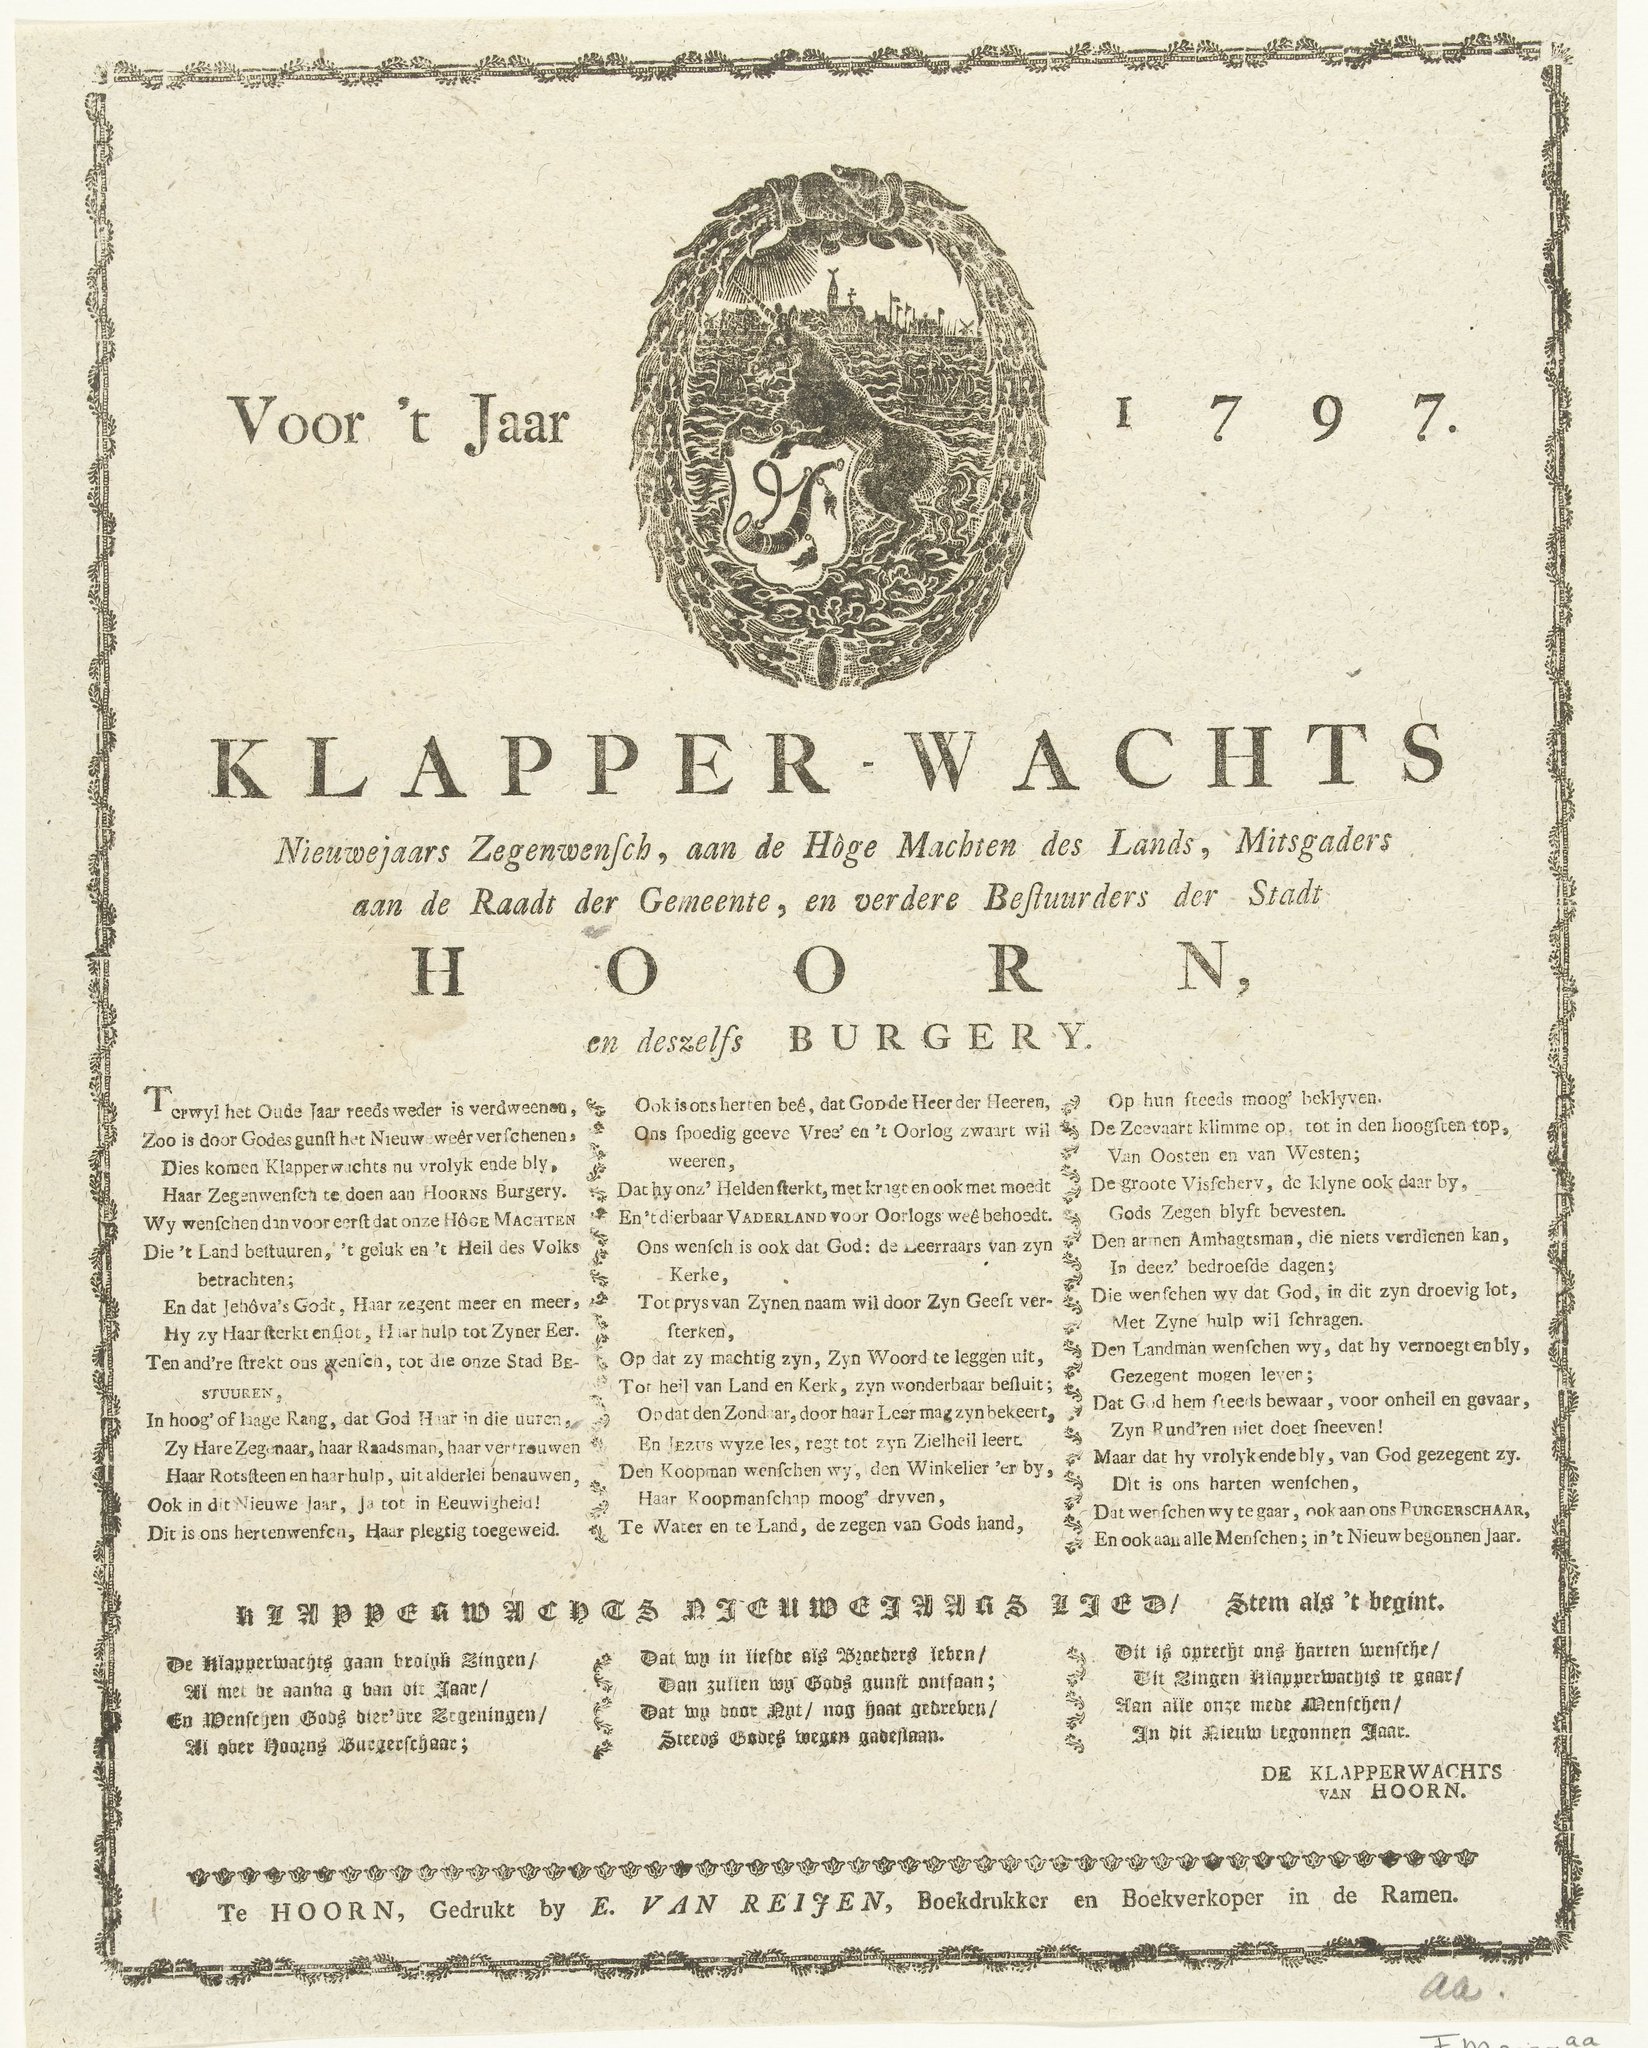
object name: new year card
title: Nieuwjaarsprent van de Hoornse klapperwacht voor het jaar 1797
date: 1796-1797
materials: paper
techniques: letterpress printing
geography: hoorn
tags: hoorn (north holland)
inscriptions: collector's mark: Lugt 2228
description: Nieuwjaarsprent van de klapperwacht (nachtwacht) van de stad Hoorn voor het jaar 1797. Opgedragen aan de bestuurders en inwoners van Hoorn. Omkranst vignet met een eenhoorn met het wapen van Hoorn op het water voor de haven, boven een vers en een lied in drie kolommen.